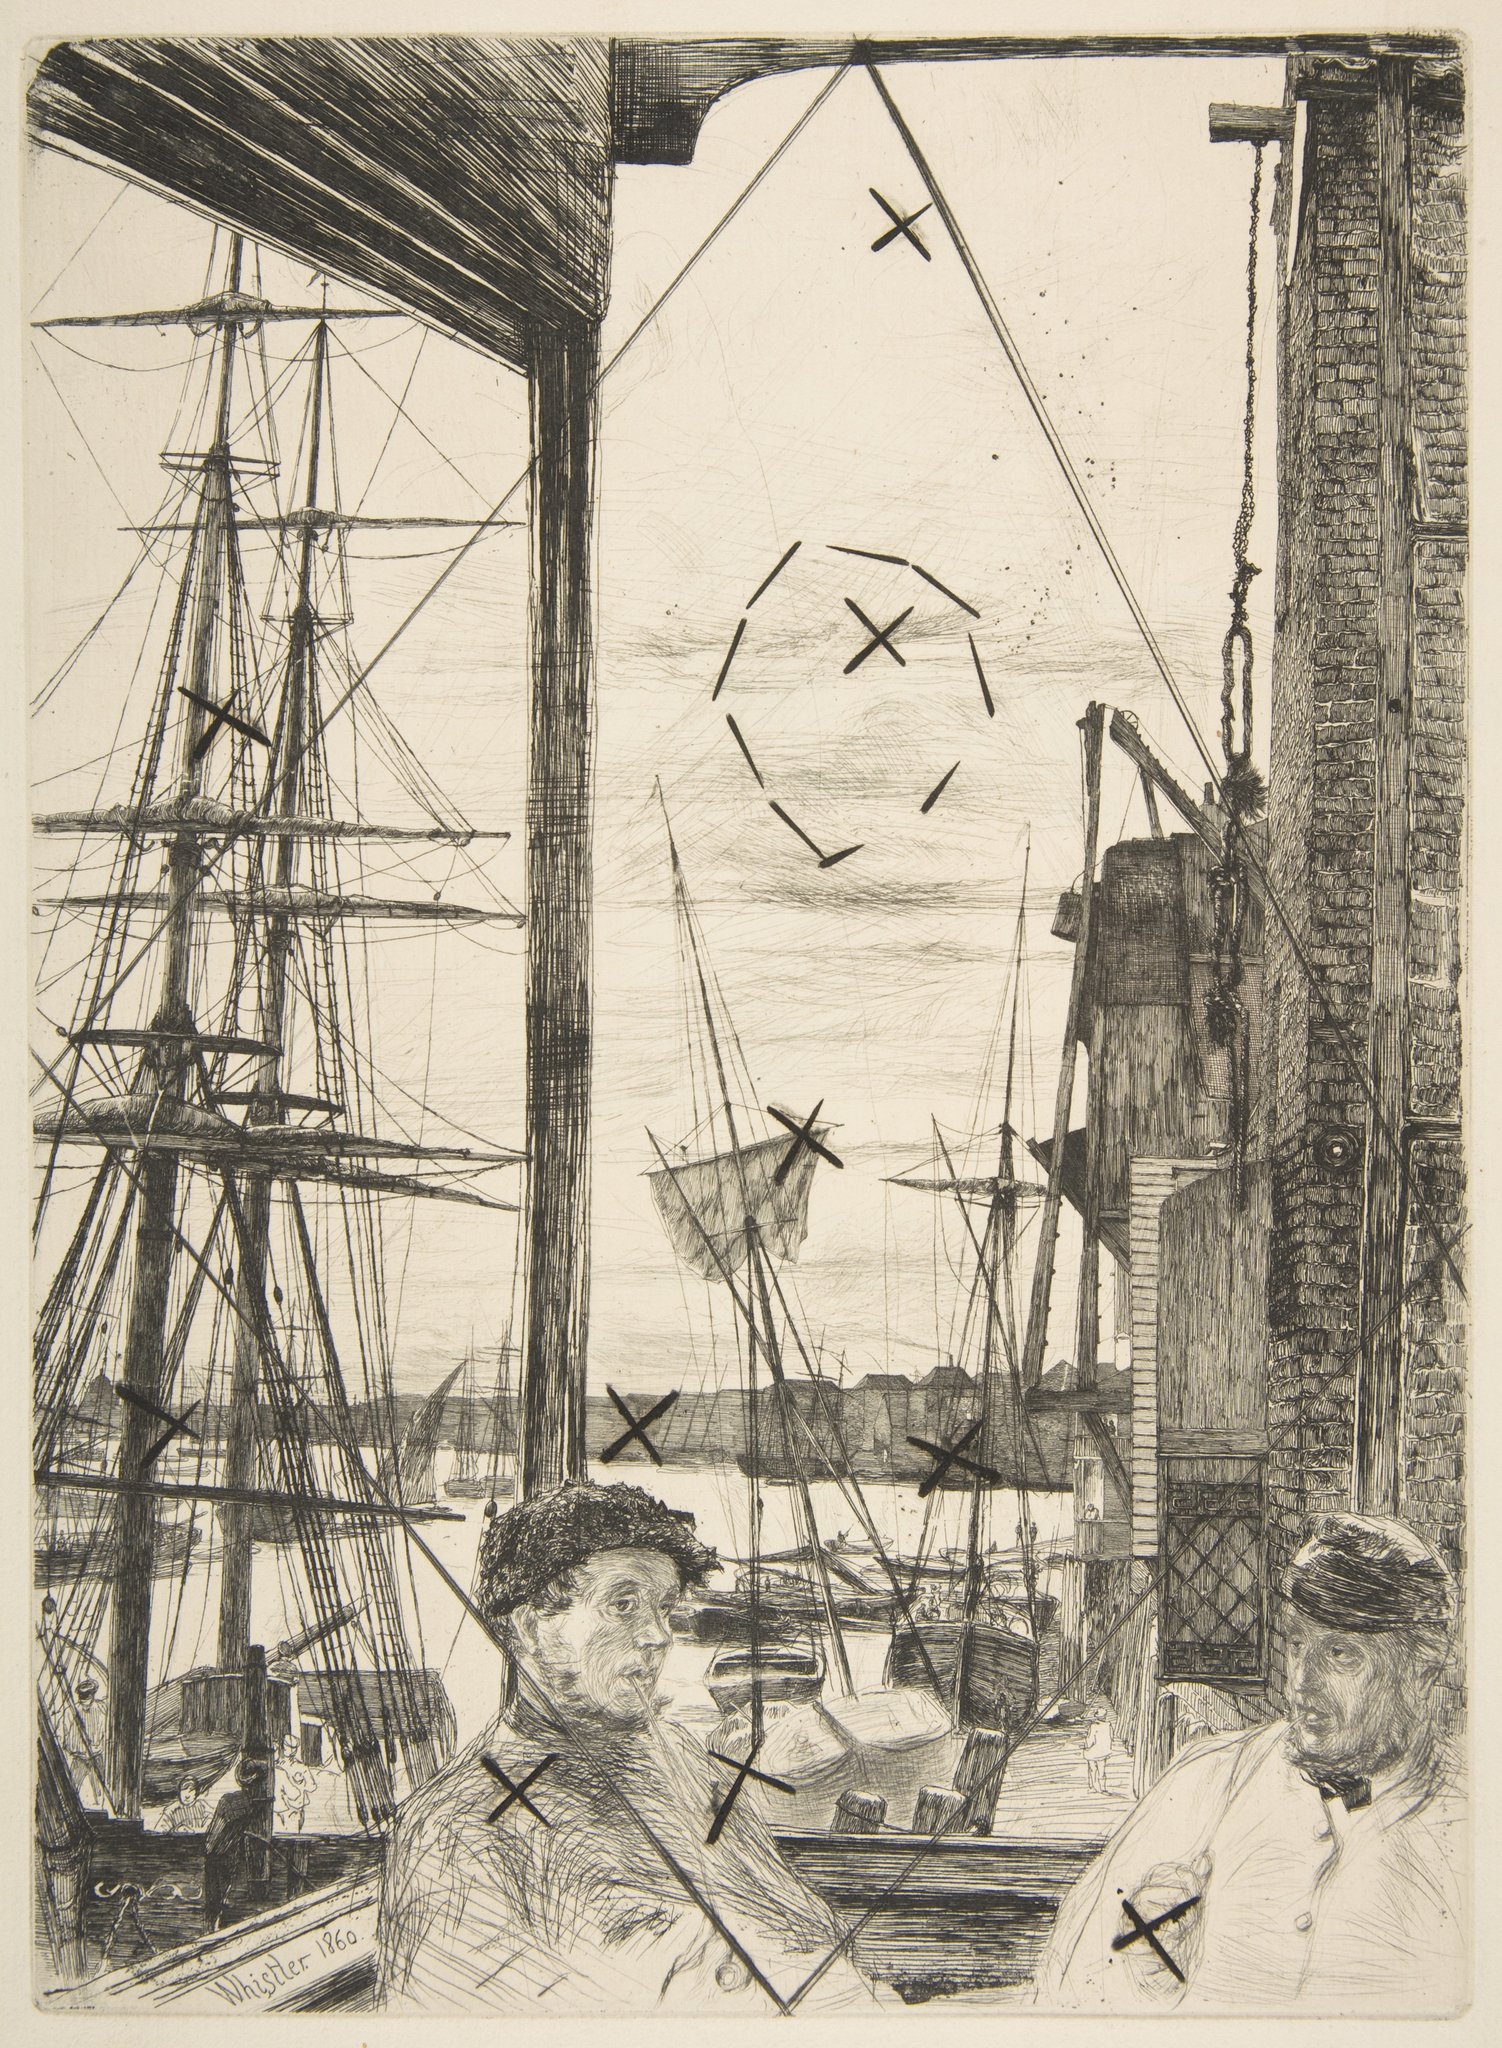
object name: print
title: Rotherhithe (Wapping)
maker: james mcneill whistler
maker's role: artist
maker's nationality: american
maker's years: 1834-1903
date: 1860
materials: ink, paper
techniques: drypoint, etching, printing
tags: men,boats